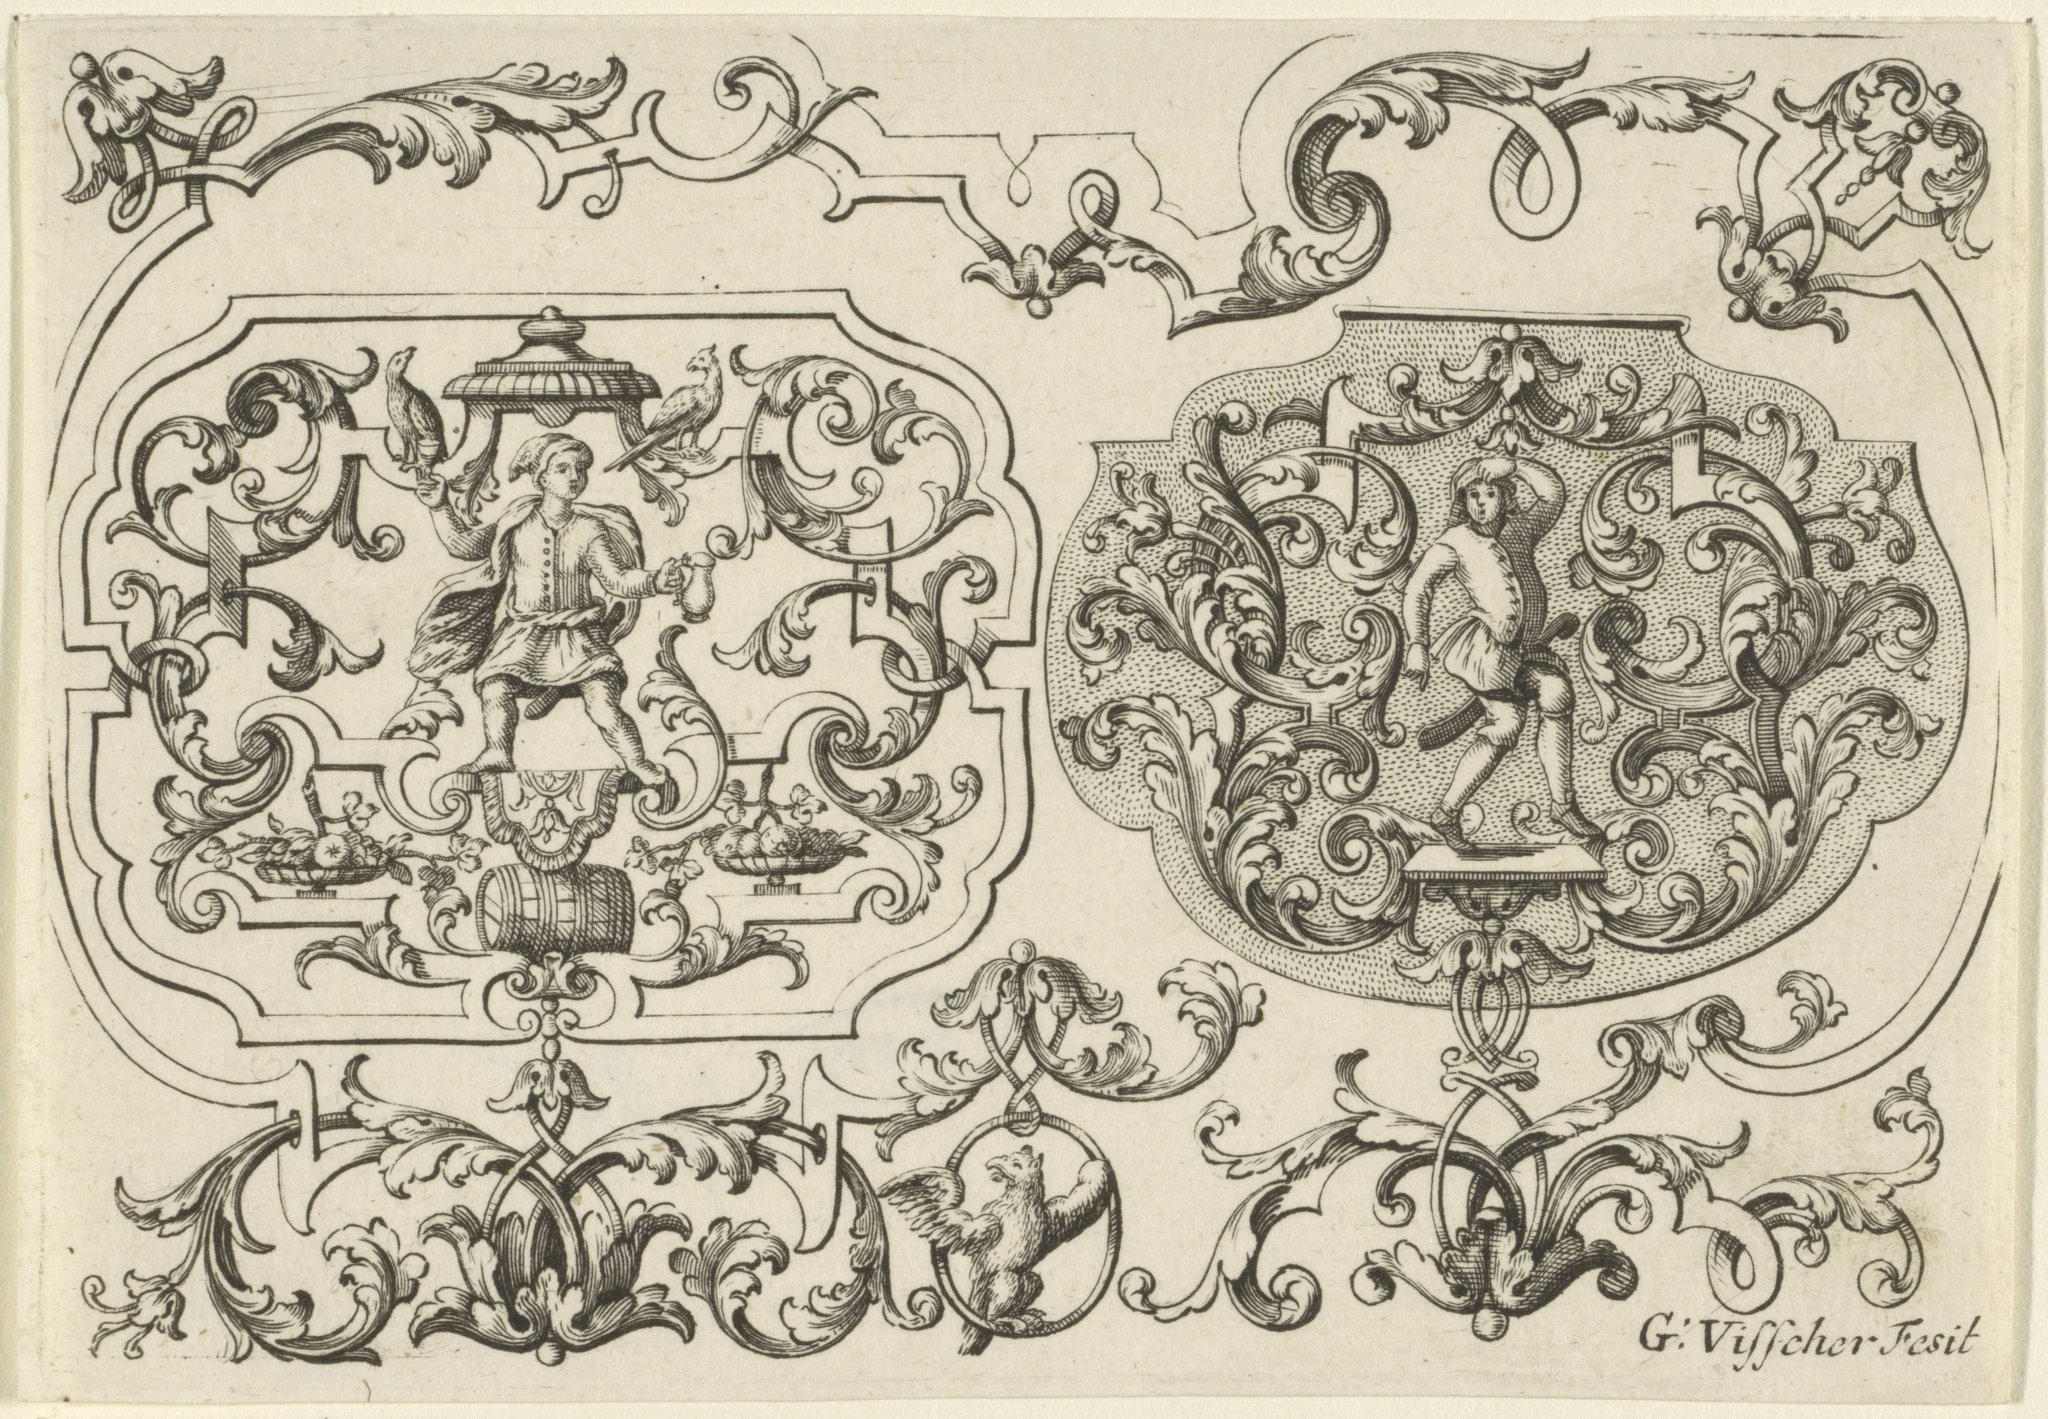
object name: print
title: Man met glas en kan in de handen en dansende man in ornamentele omlijsting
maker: gerrit visscher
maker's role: print maker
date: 1690-1710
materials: paper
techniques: engraving, etching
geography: amsterdam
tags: glass of wine, man dancing alone, foliage, tendrils, branches ~ ornament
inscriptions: collector's mark: Lugt 2228